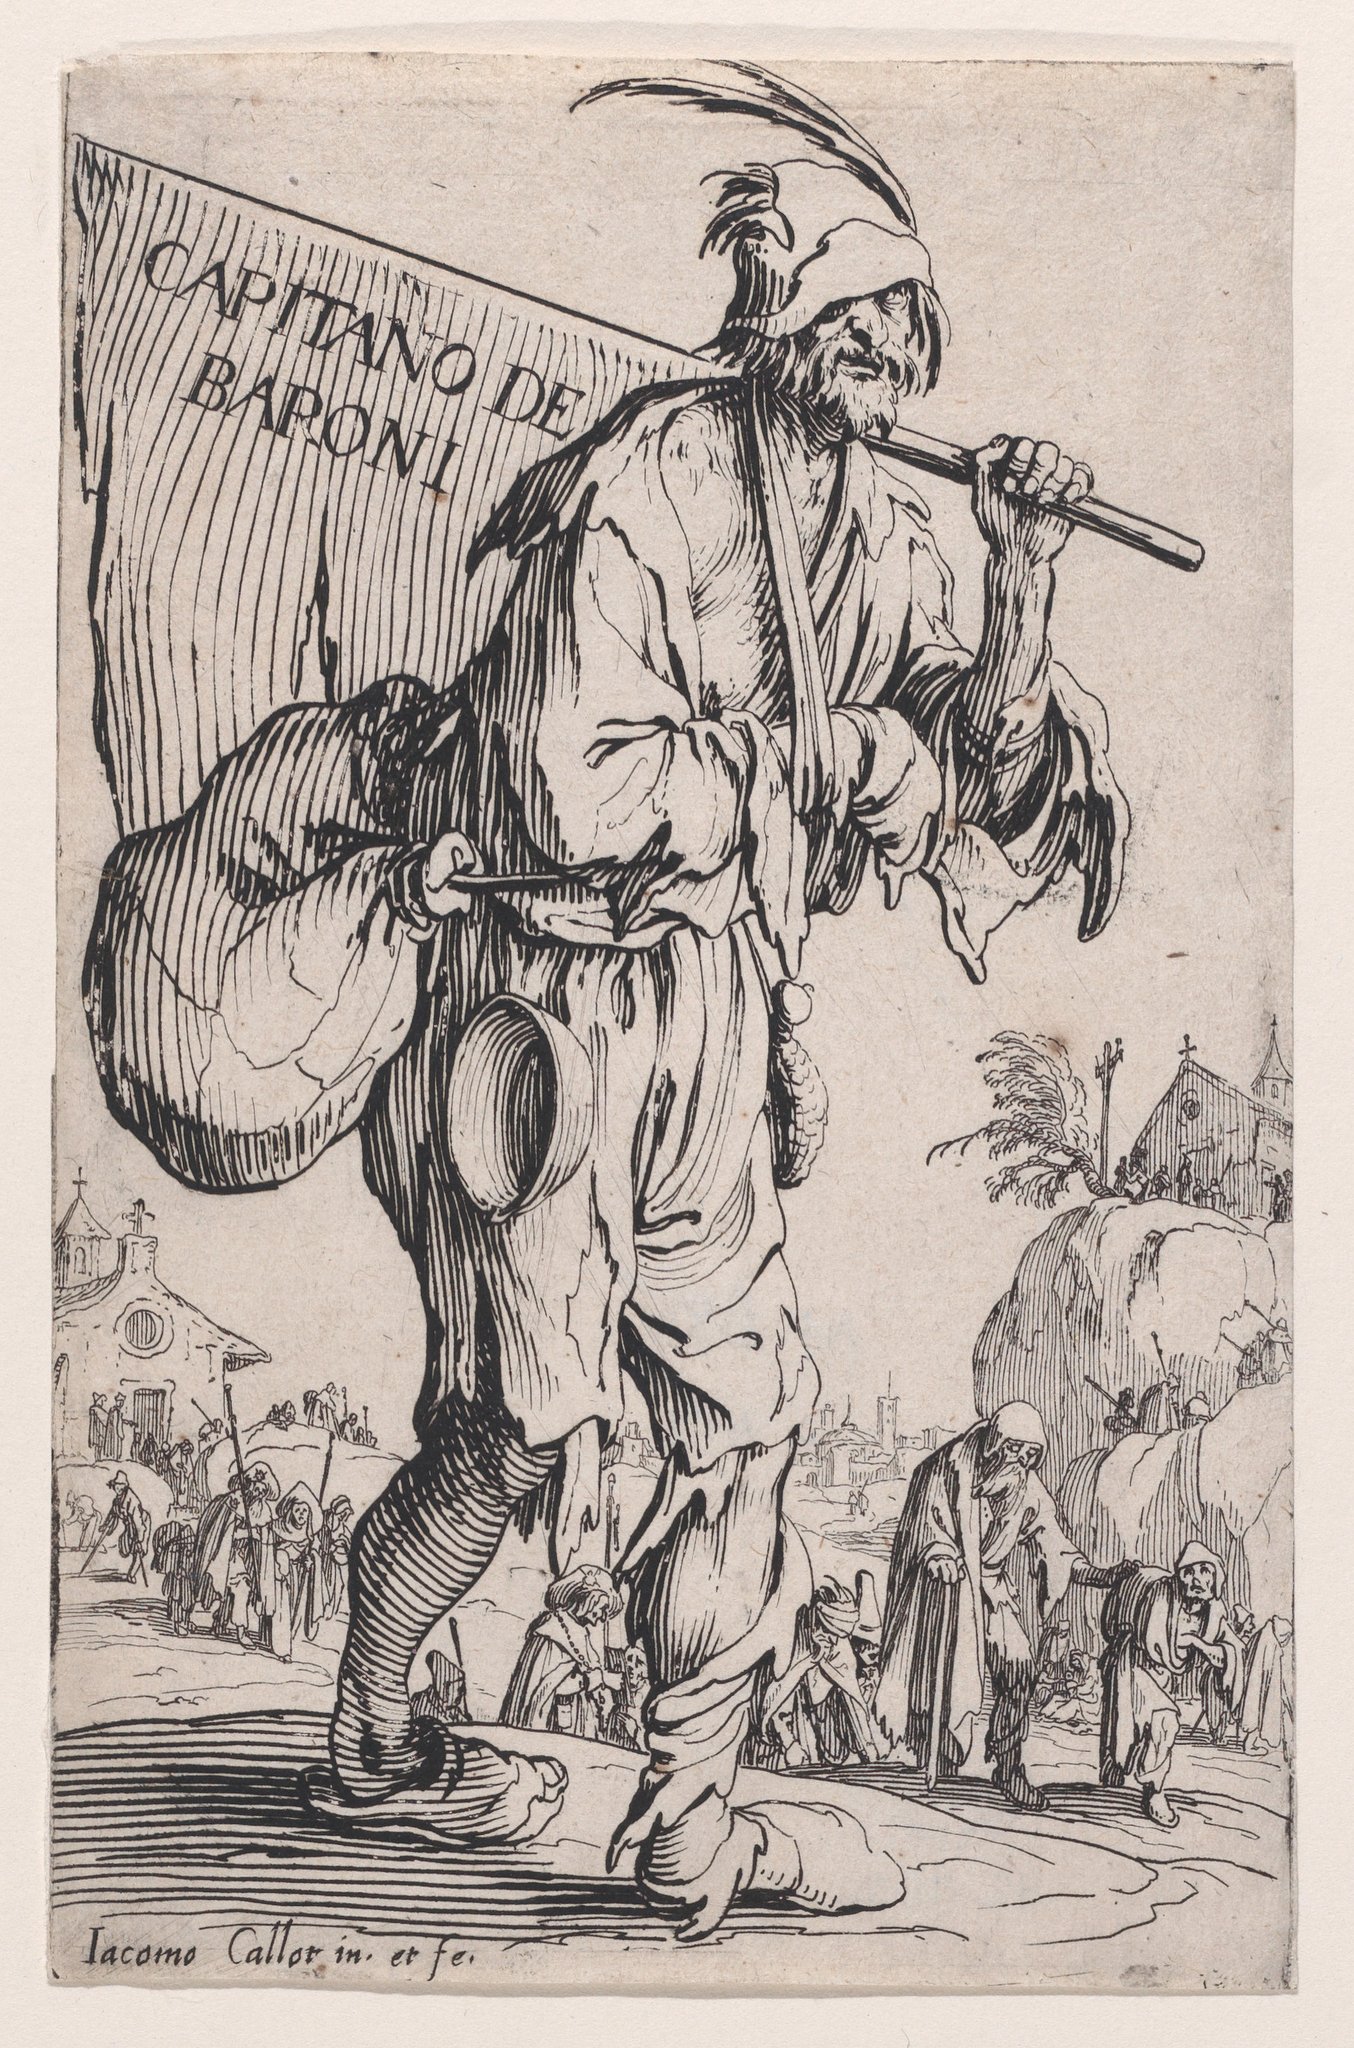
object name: print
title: Frontispiece, from "Les Gueux suite appelée aussi Les Mendiants, Les Baroni, ou Les Barons" (The Beggars, also called the Barons)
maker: jacques callot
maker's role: artist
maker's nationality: french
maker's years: 1592-1635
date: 1623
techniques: etching